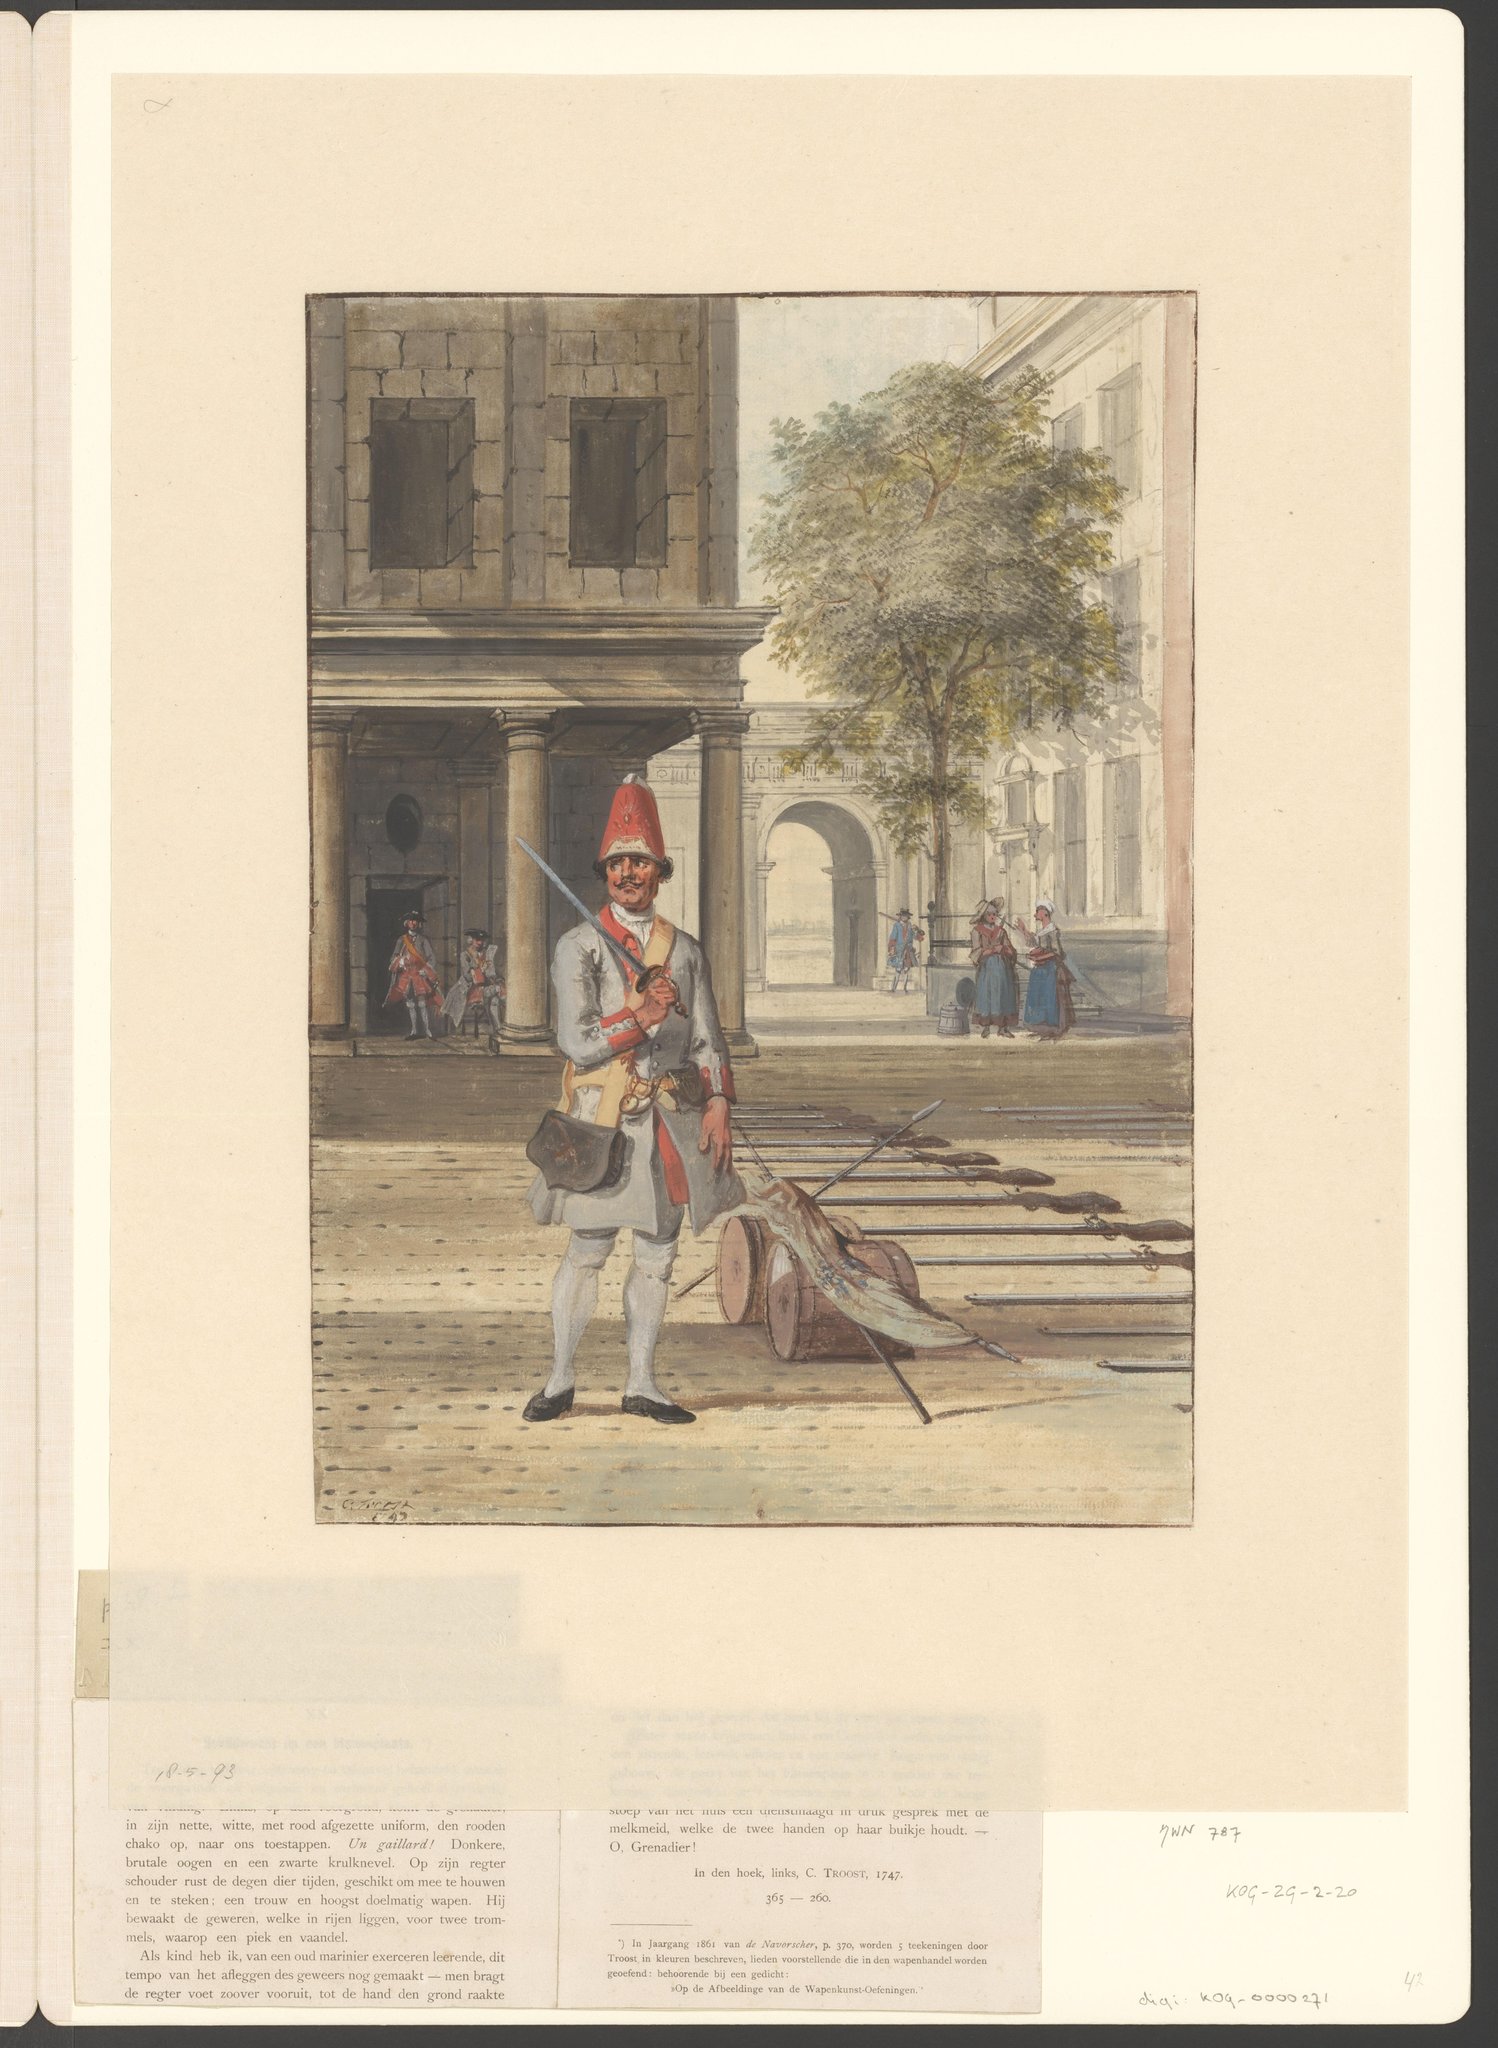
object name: drawing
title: Grenadier op wacht bij een kazerne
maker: cornelis troost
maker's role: draughtsman, painter, print maker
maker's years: 1696-1750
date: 1747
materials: gouache, paper, watercolor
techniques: brush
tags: drum (musical instrument), firearms: rifle, the soldier; the soldier's life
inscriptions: collector's mark: Lugt 1641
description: Grenadier op wacht bij een kazerne. Naast hem een rij geweren en twee trommels.